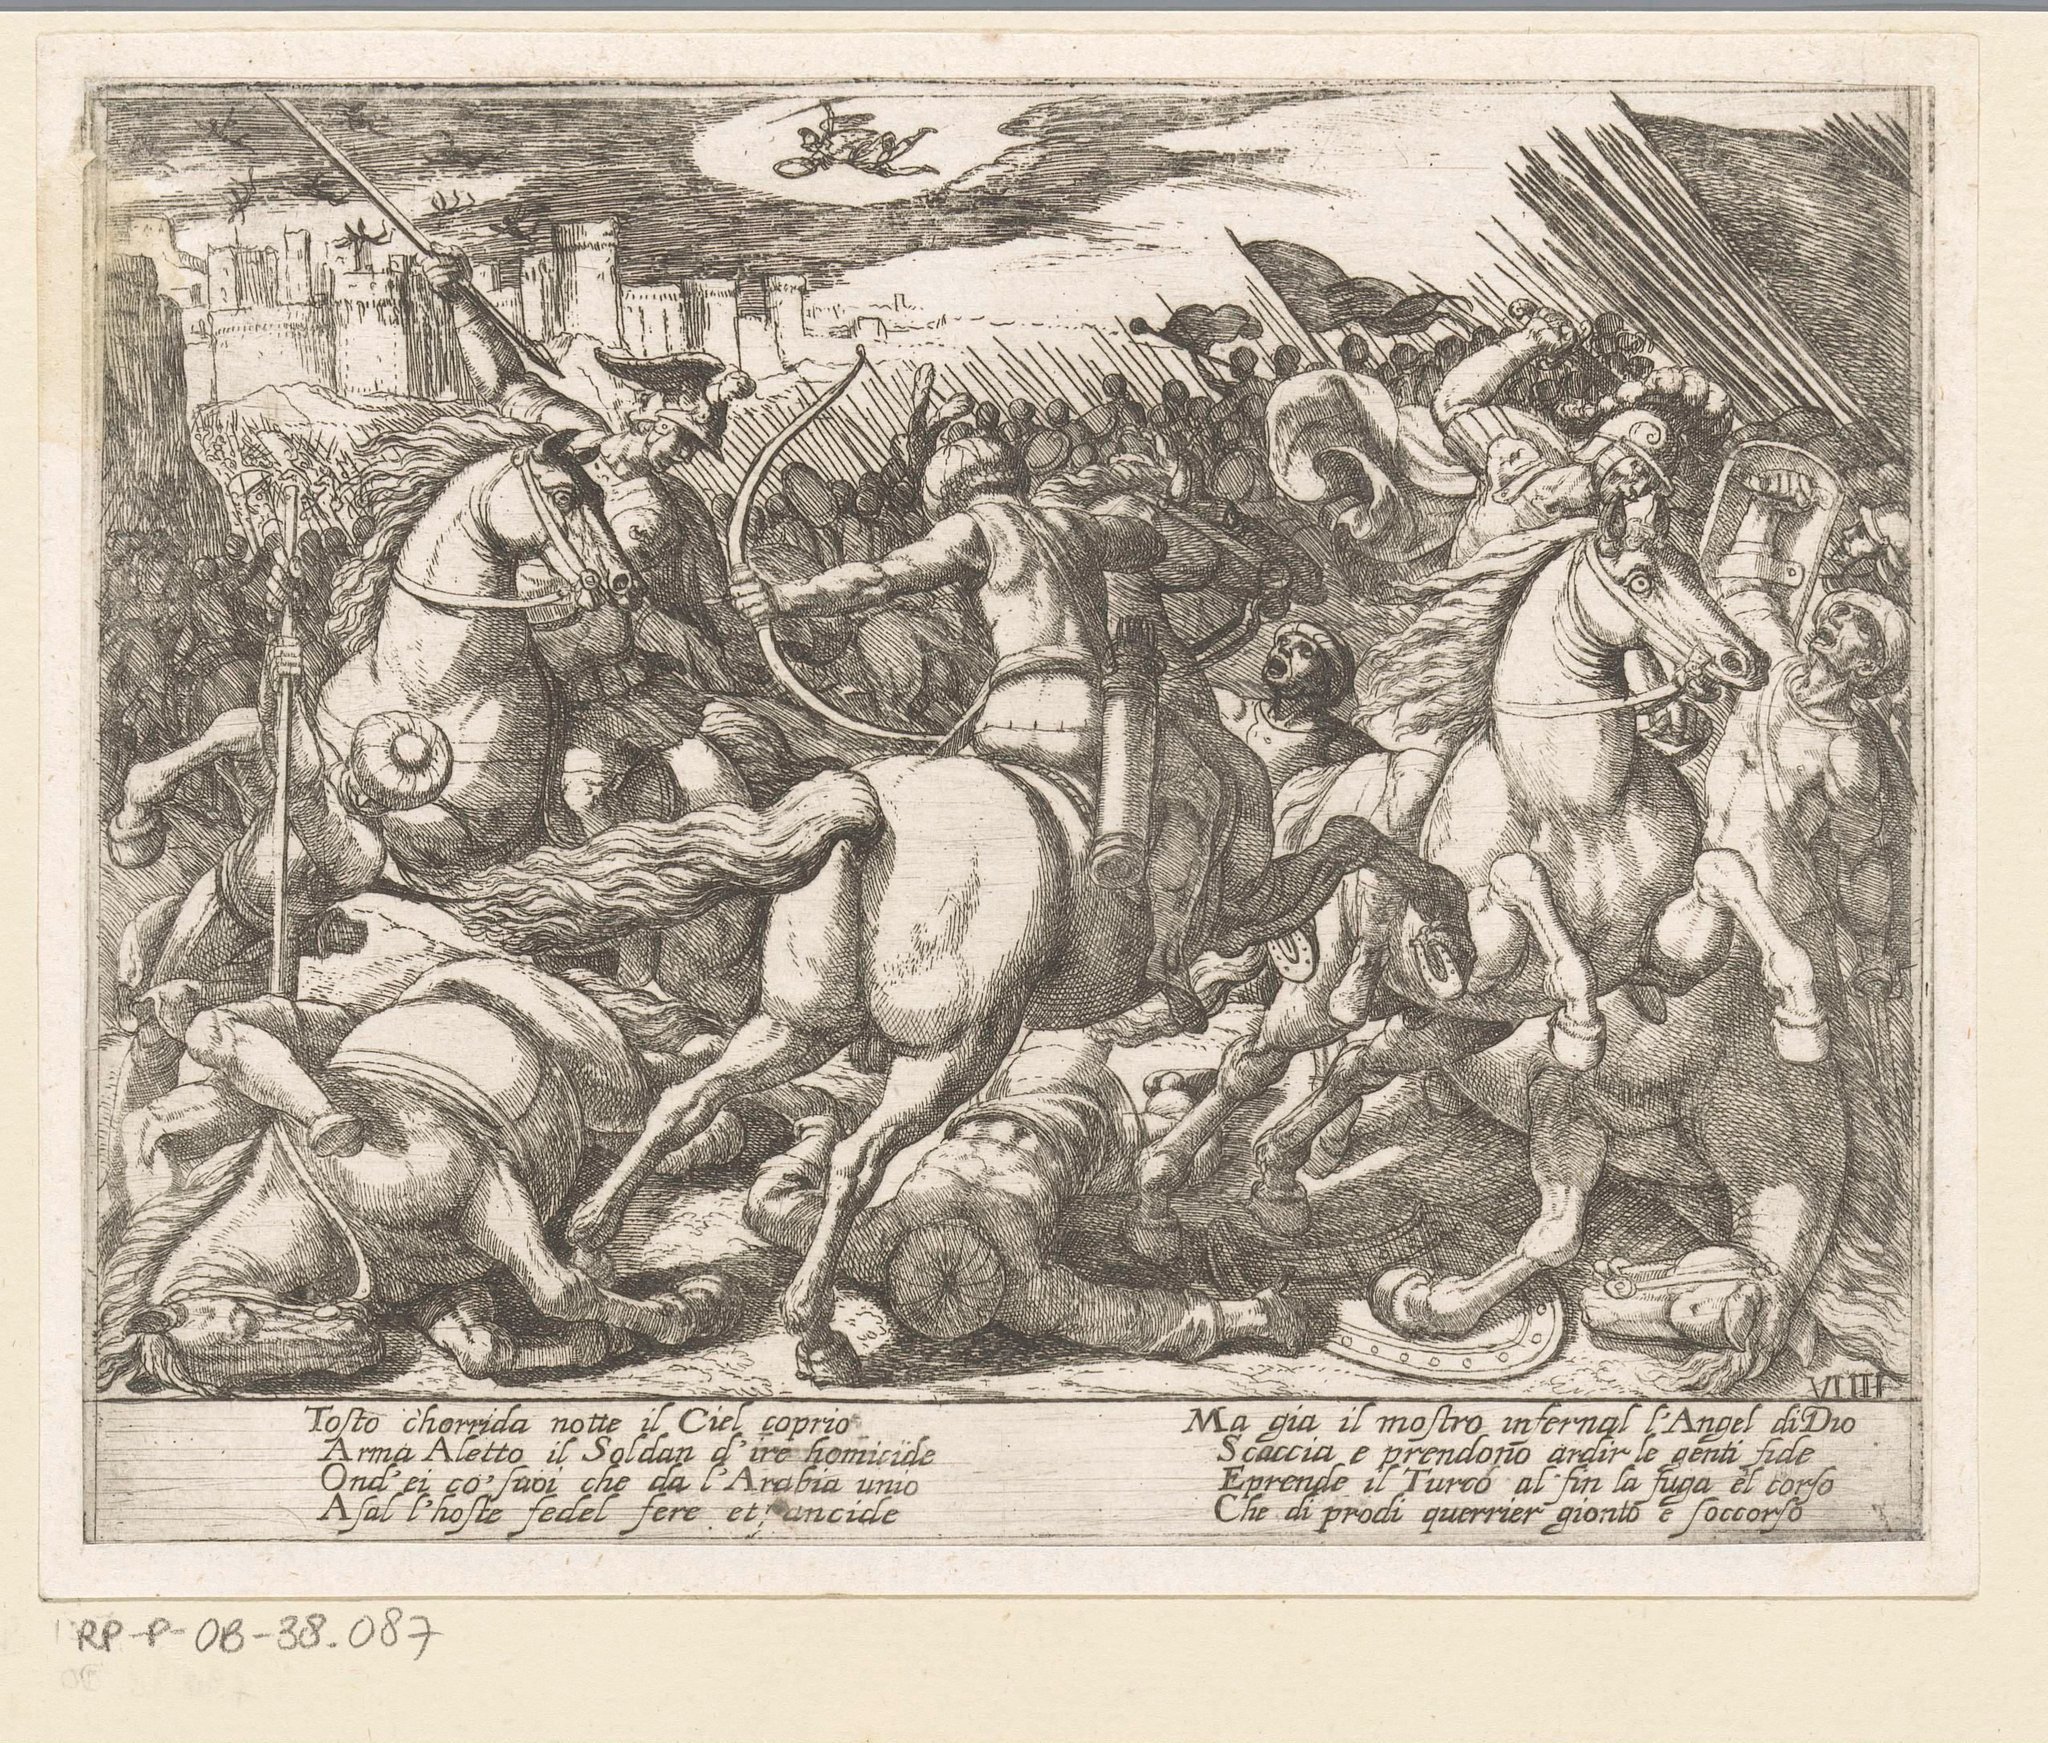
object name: print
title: Illustratie bij Canto IX van Tasso's 'Gerusalemme Liberata'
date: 1565-1630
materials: paper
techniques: etching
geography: italy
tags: the archangel michael (often in armour with sword or lance), battle, warfare; military affairs (+ cavalry, horsemen), militant proselytizing: religious war, crusade, etc., (scenes from) specific works of literature: tasso, gerusalemme liberata, knight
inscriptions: collector's mark: Lugt 240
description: Deze prent maakt deel uit van een reeks van twintig prenten (+ opdracht) met voorstellingen van scènes uit Tasso's 'Jeruzalem verlost', een episch gedicht geschreven door de Italiaanse dichter Torquato Tasso en voor het eerst gepubliceerd in 1581. Het verhaal vertelt grotendeels in fictie over de Eerste Kruistocht waarin de christenen, geleid door Godfried van Bouillon, de strijd aangaan met de moslims om het Beleg van Jeruzalem.